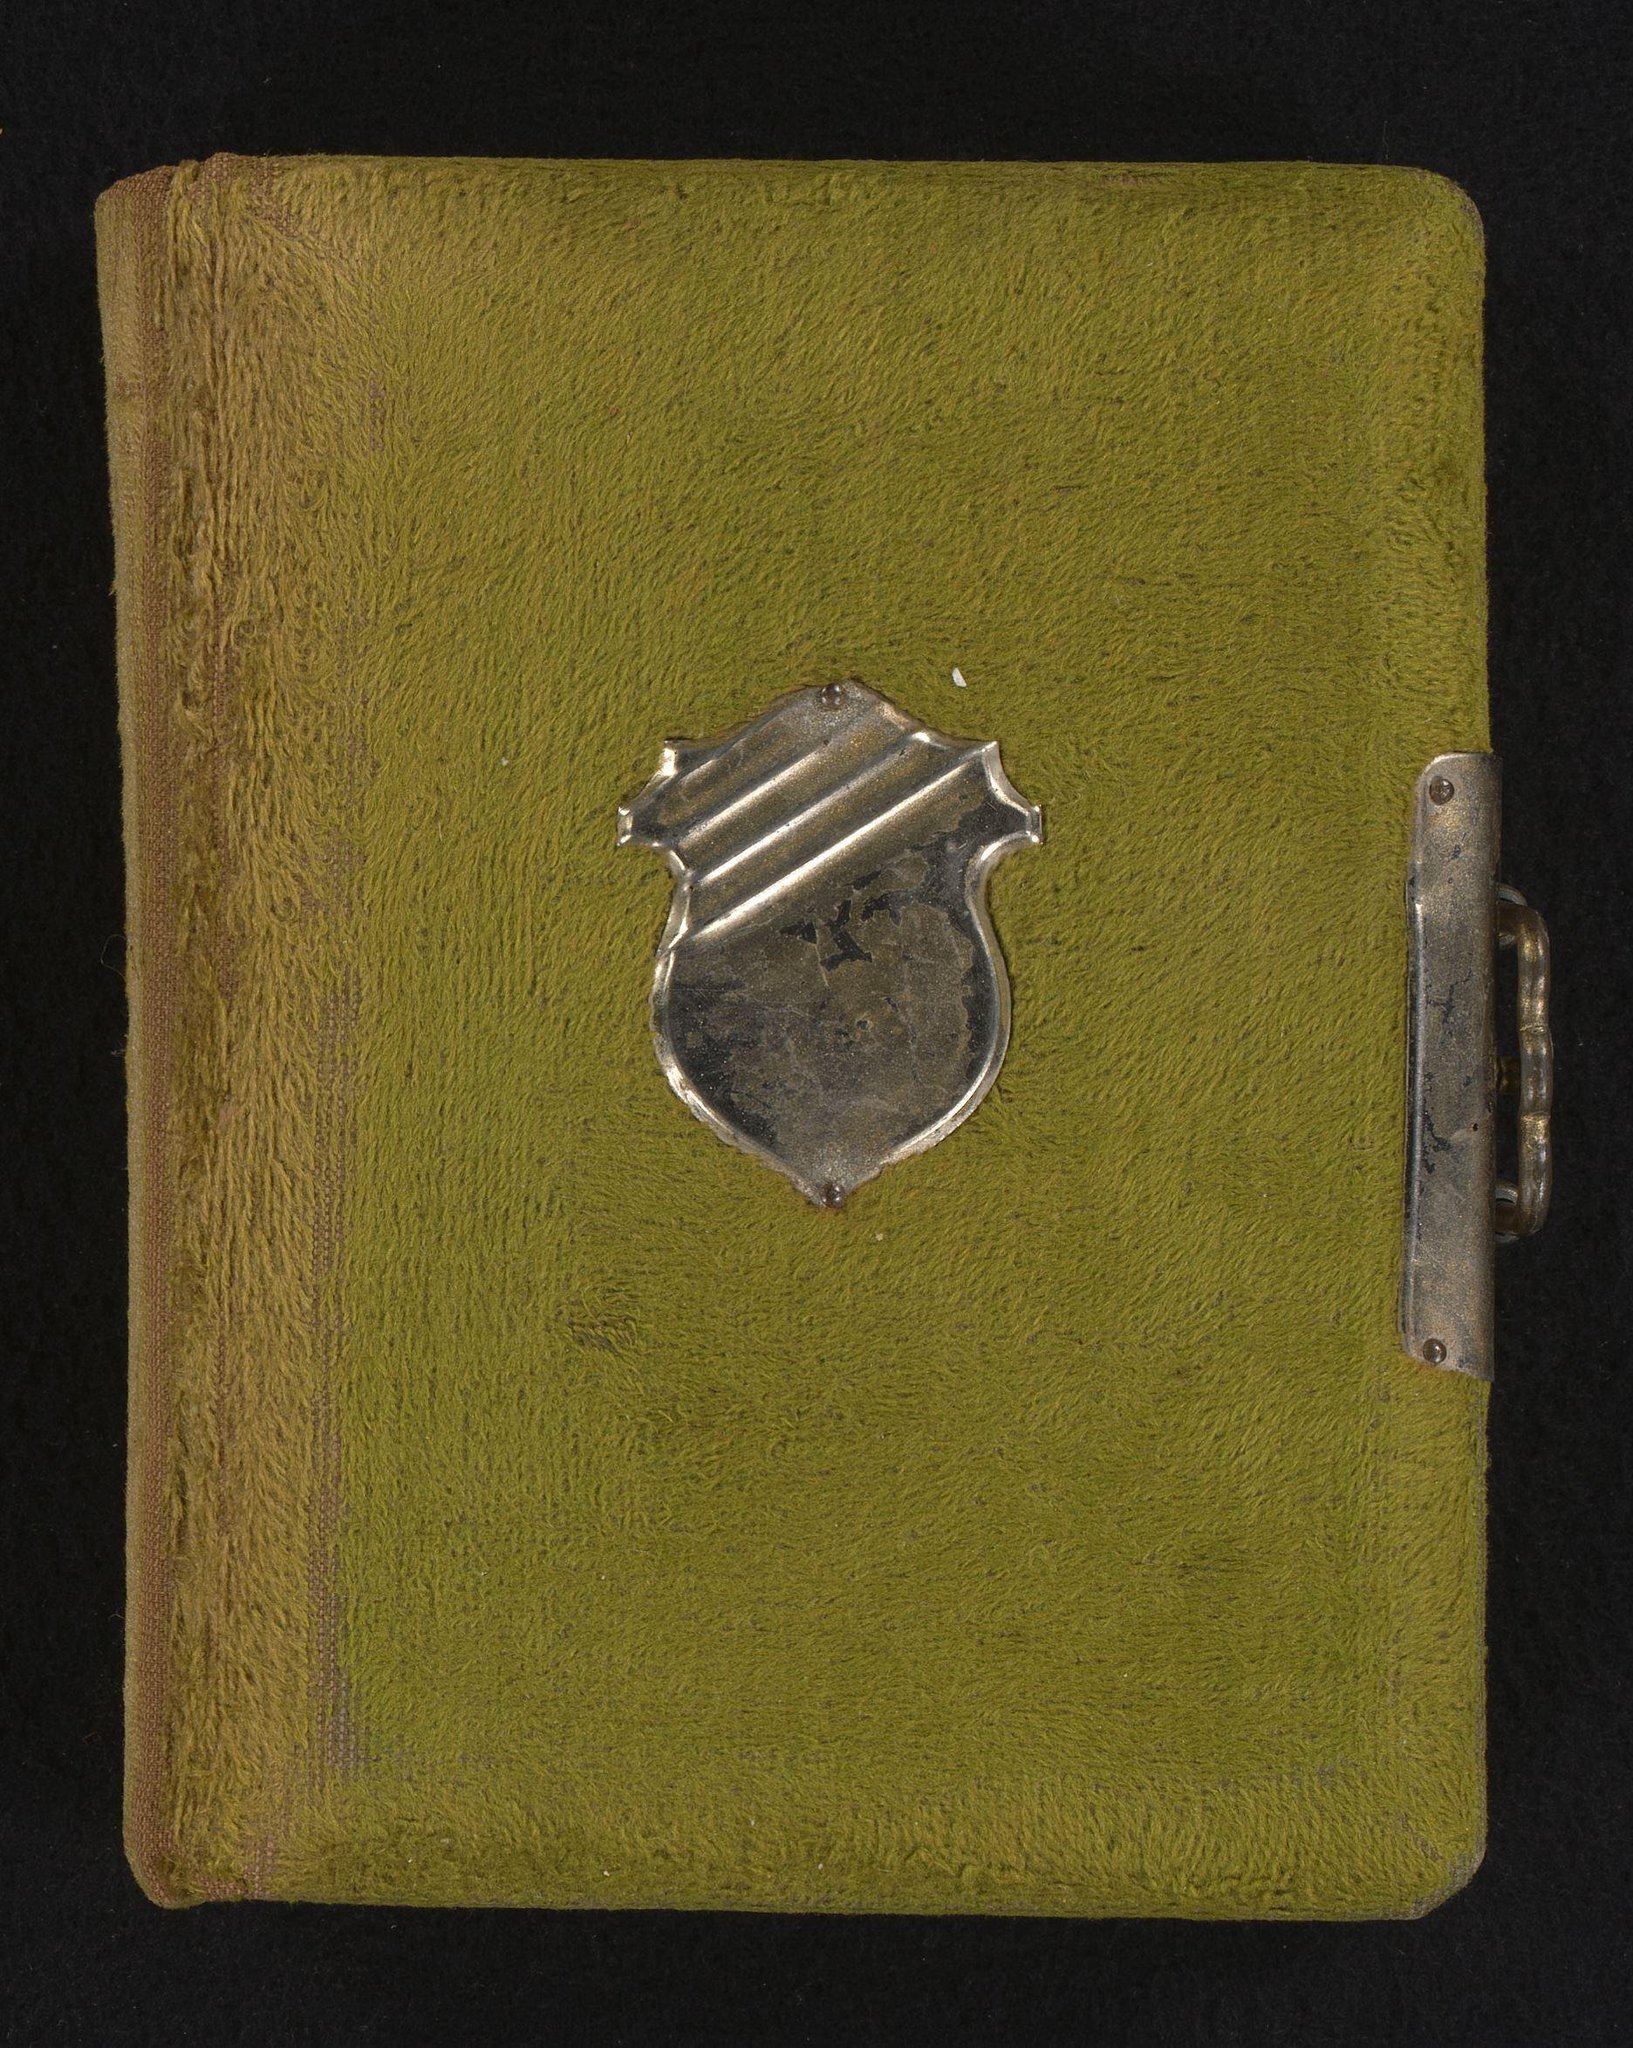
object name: slip in album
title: Frans album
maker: Anonymous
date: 1860-1920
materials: cardboard, metal, photographic support, textile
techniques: albumen print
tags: rome, leo xiii, adult woman, adult man, historical persons, organization, functionaries and dignitaries in churches and in related institutions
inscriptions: inscription: ‘Dienst/ Verspreide/ Rijkskollekties (...)’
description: Fotoalbum met 22 pagina's met in totaal 23 foto's. Het album bevat voornamelijk portretten van onder meer geestelijken, paus Leo XIII, mannen in uniform en vrouwen en kinderen. De meeste foto's zijn cartes-de-visite, waarvan er een los in het album zit.